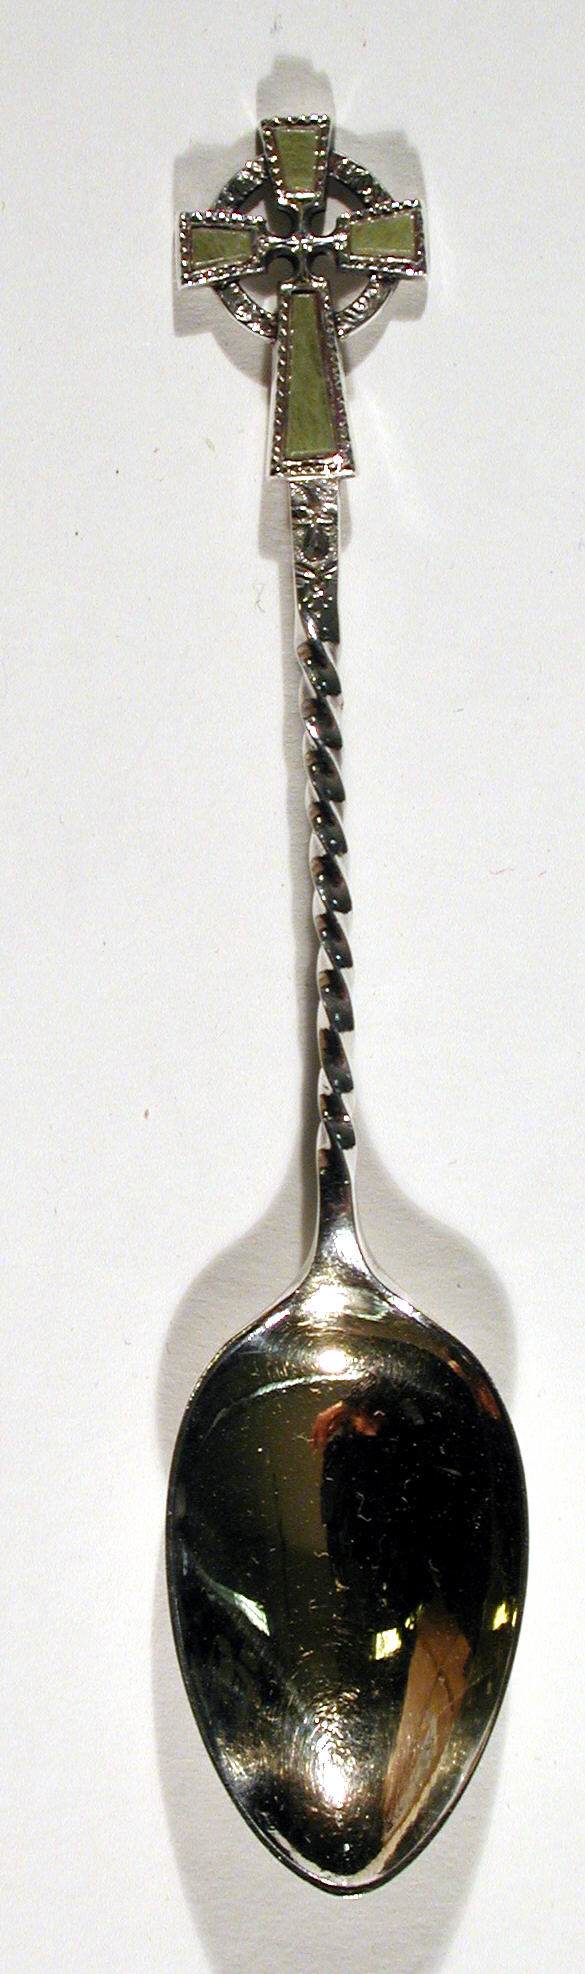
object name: souvenir spoon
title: Souvenir spoon with finial in form of Celtic cross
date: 1895-1896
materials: gilt, silver, stone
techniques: inlay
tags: cross